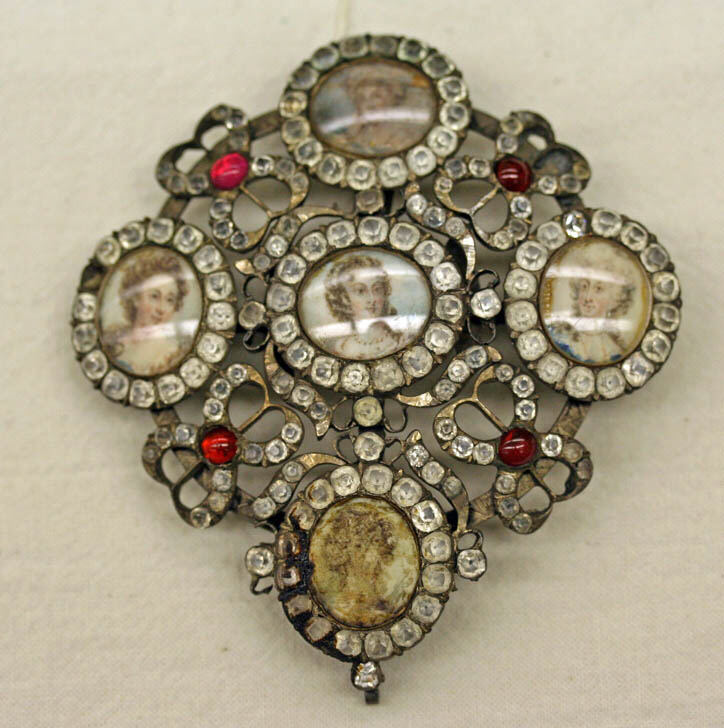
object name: brooch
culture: british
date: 1701-1733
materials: glass, metal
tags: portraits,women